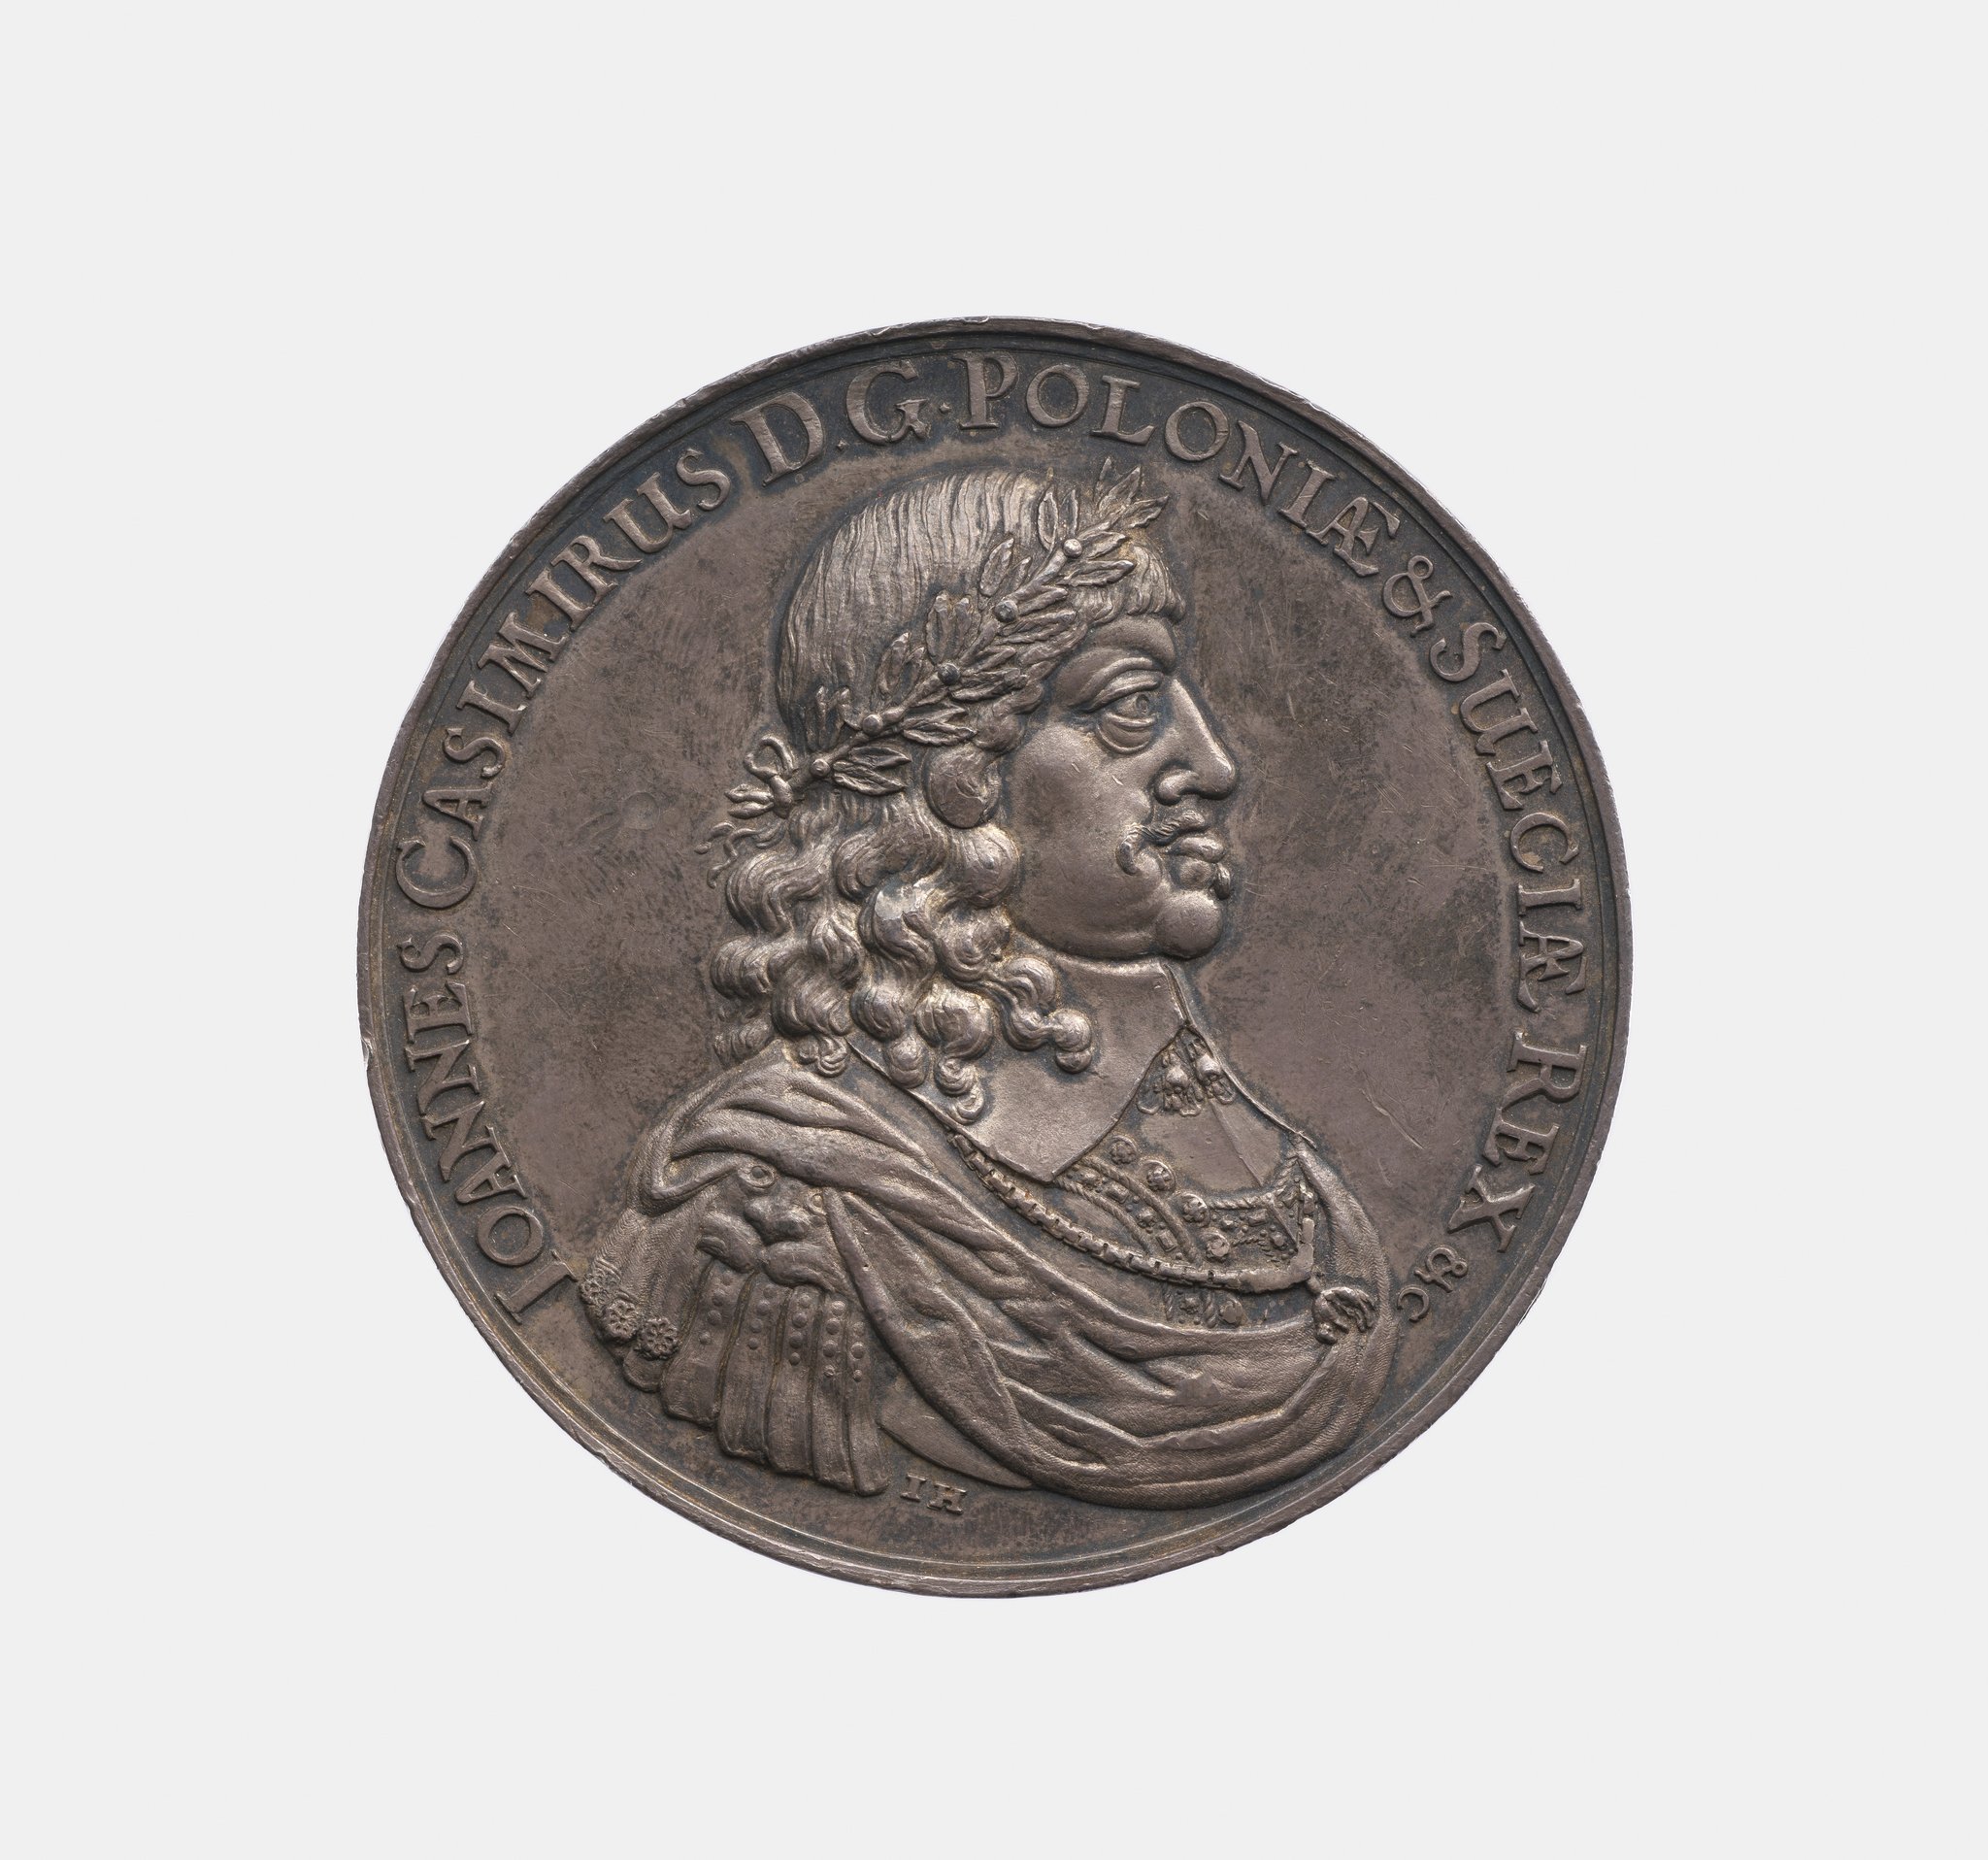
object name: medal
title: John Casimir 1609-72, King of Poland 1648-68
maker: johann hoehn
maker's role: artist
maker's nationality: german, danzig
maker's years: 1637-1693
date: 1658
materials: silver